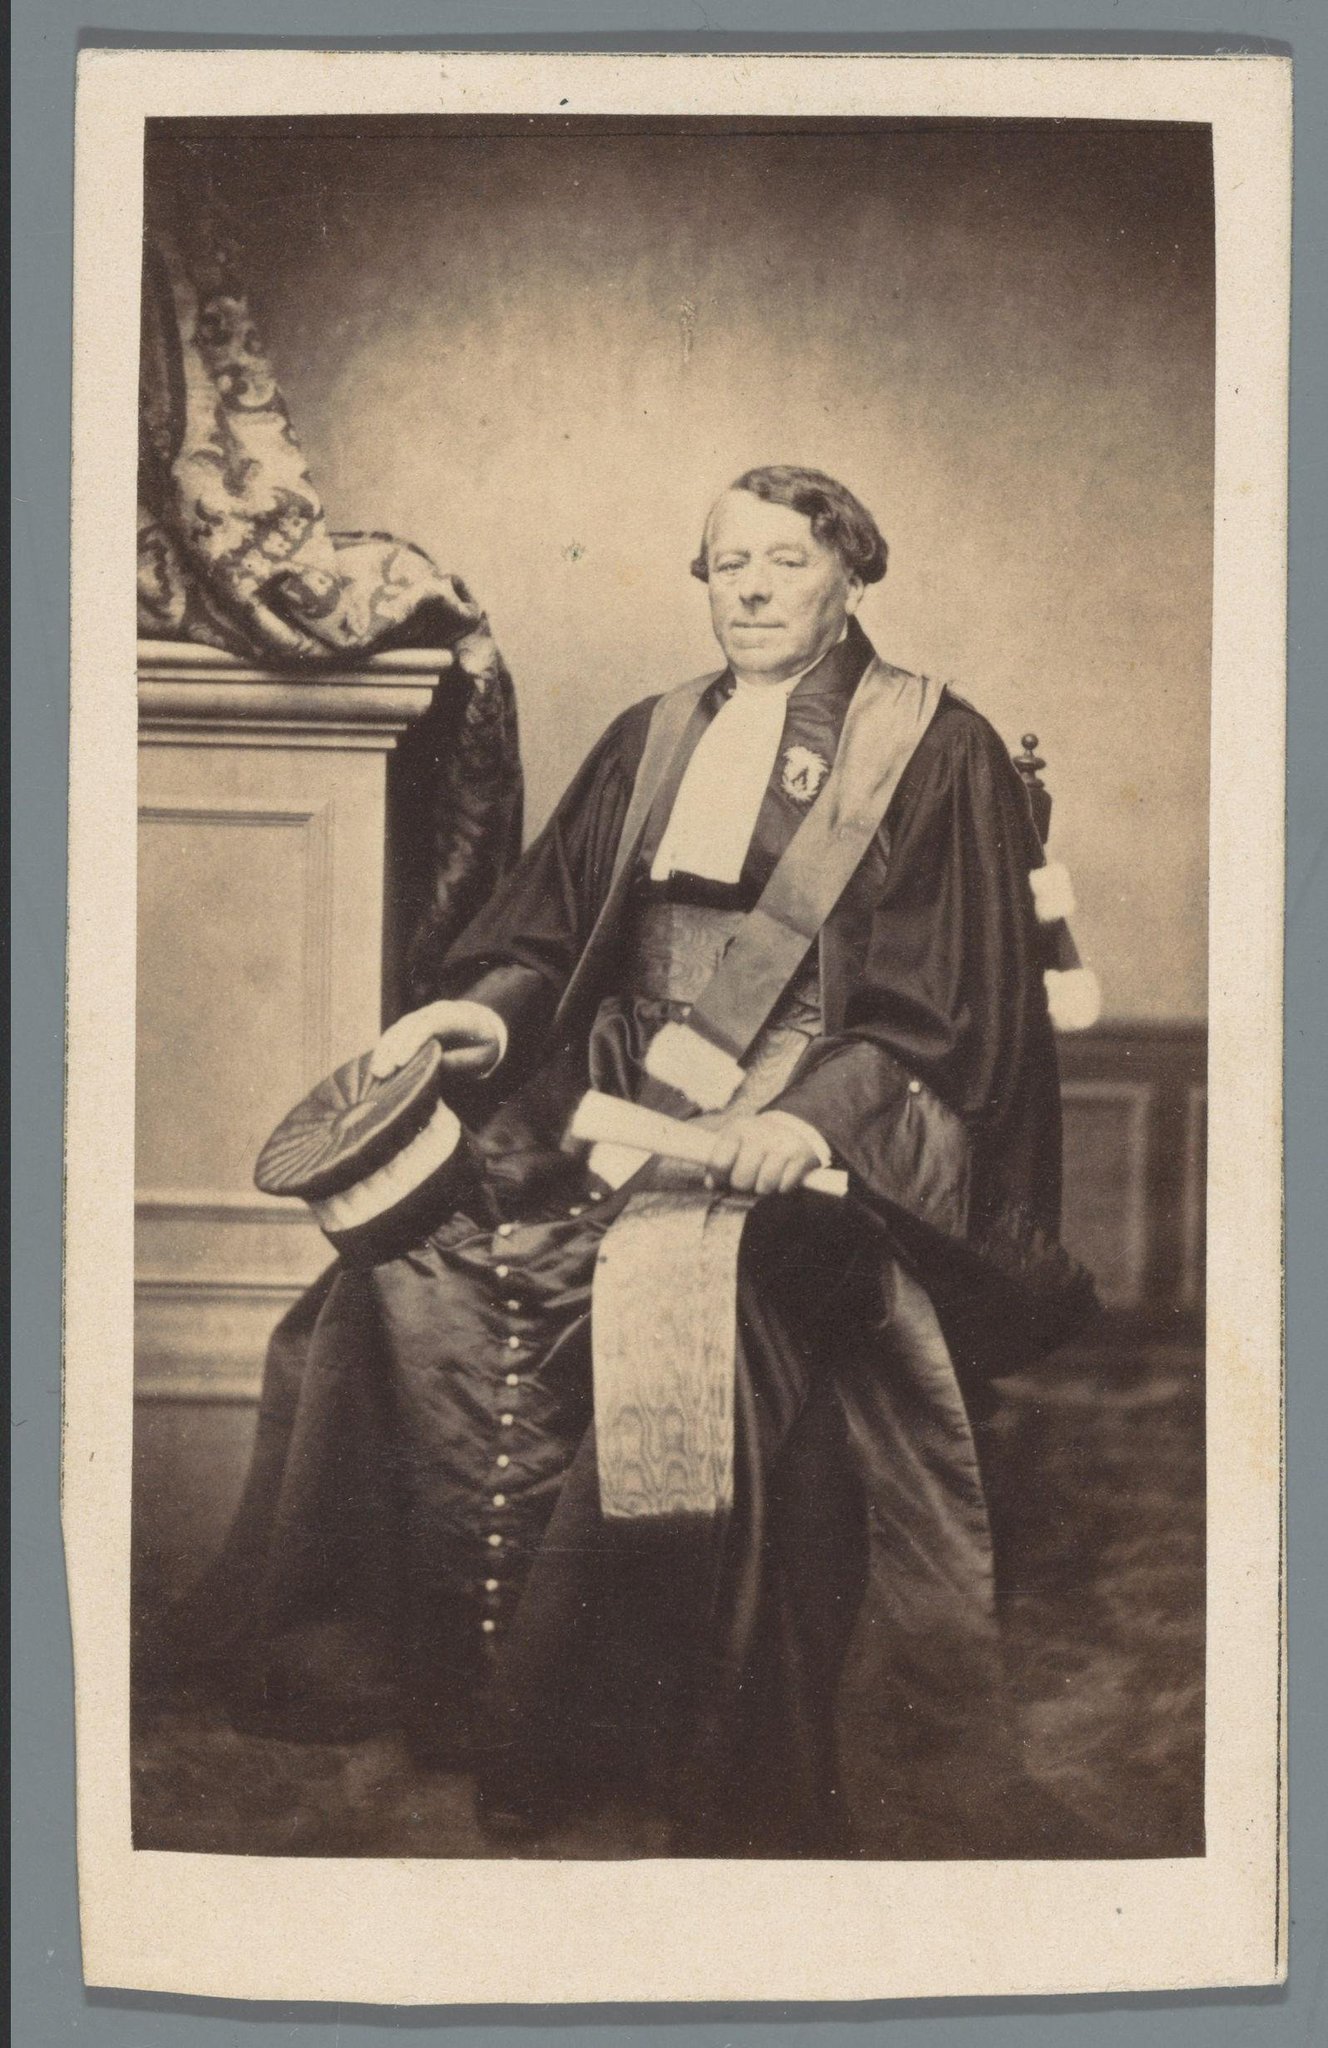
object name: photograph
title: Portret van een onbekende rechter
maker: charles herbert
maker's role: fotograaf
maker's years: 1829-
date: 1866-1872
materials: cardboard, paper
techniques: albumen print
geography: beauvais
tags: anonymous historical person portrayed, magistracy, judges, beauvais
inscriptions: inscription: ‘Photographie/ Herbert/ breveté S.G.D.G./ 7, Rue du Lion Rampant 7,/ Beauvais/ Seul représentant du Panthéon de l'ordre Impérial/ de la Légion d'honneur pour le Département/ de l'Oise’